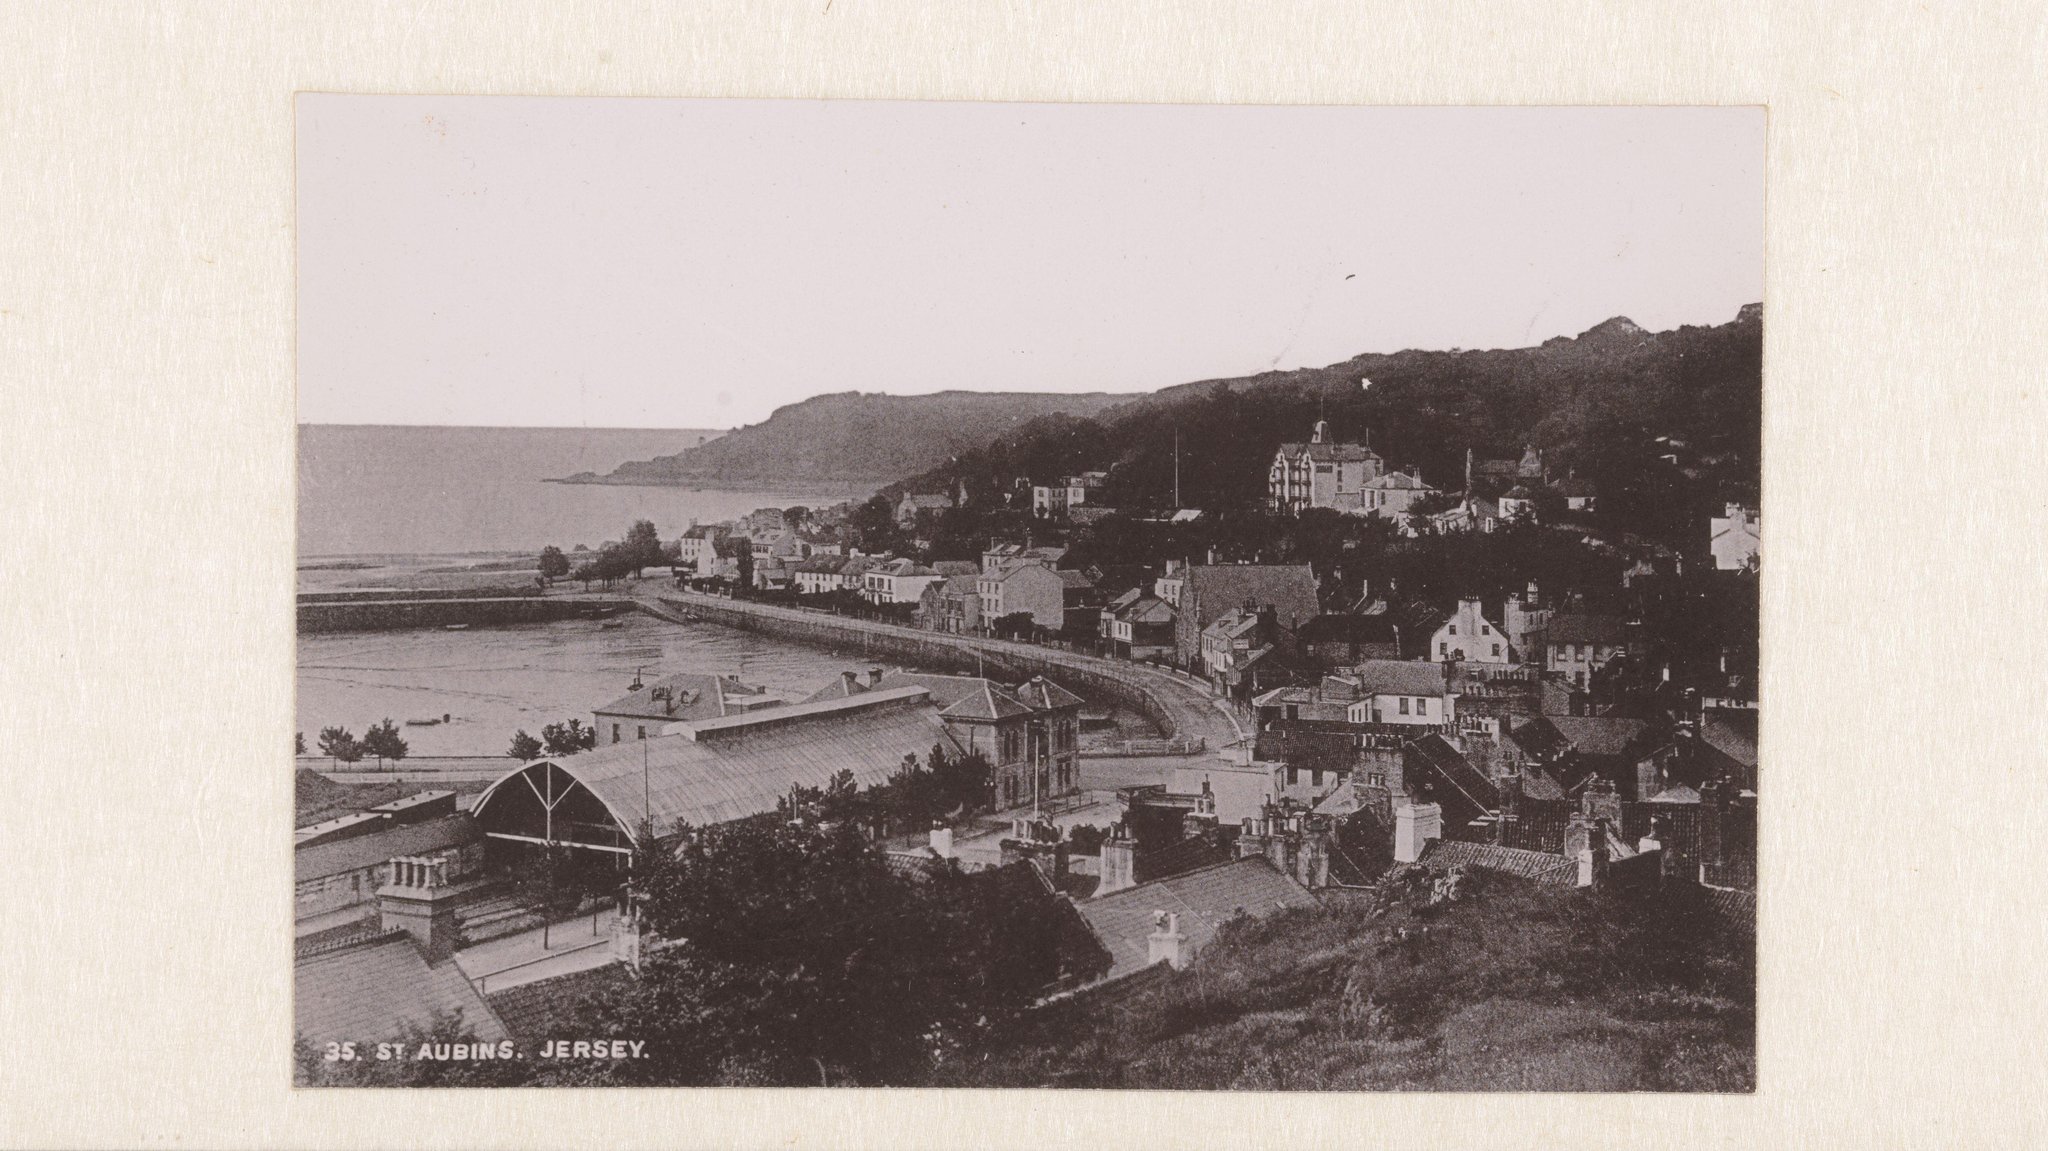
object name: photomechanical print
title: St. Aubins, Jersey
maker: Anonymous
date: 1870-1930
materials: paper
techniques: photograph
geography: jersey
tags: harbour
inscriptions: number: ‘35.’